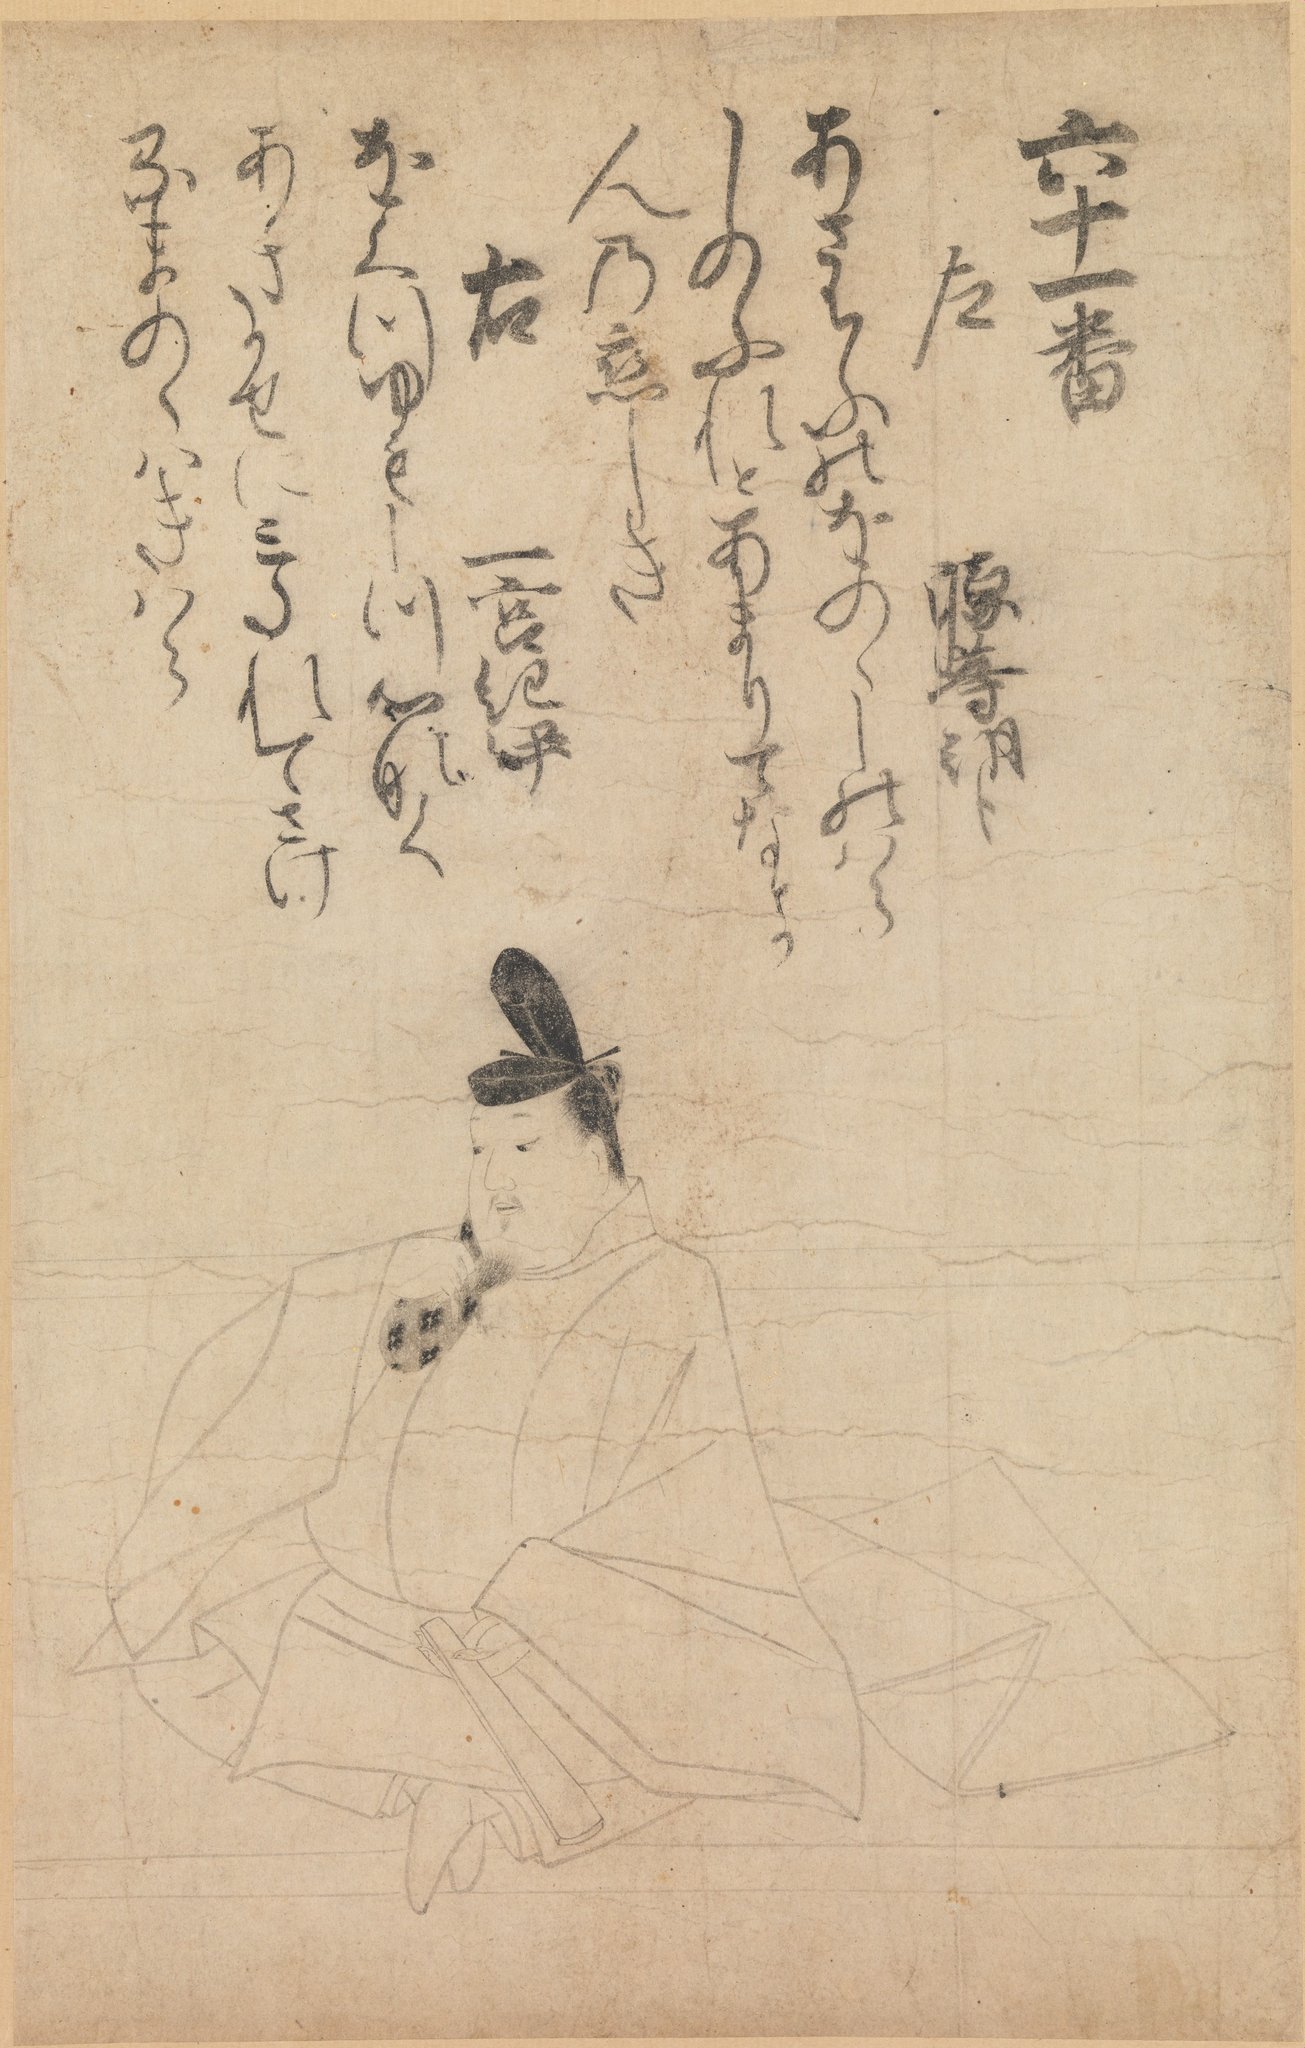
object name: hanging scroll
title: Competition Between Poets of Different Eras (Jidai fudō uta awase), depicting the poet Minamoto no Hitoshi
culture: japanese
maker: fujiwara no nobuzane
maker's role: calligrapher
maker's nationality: japanese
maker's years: 1176-1265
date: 1201-1300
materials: ink, paper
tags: poetry,men